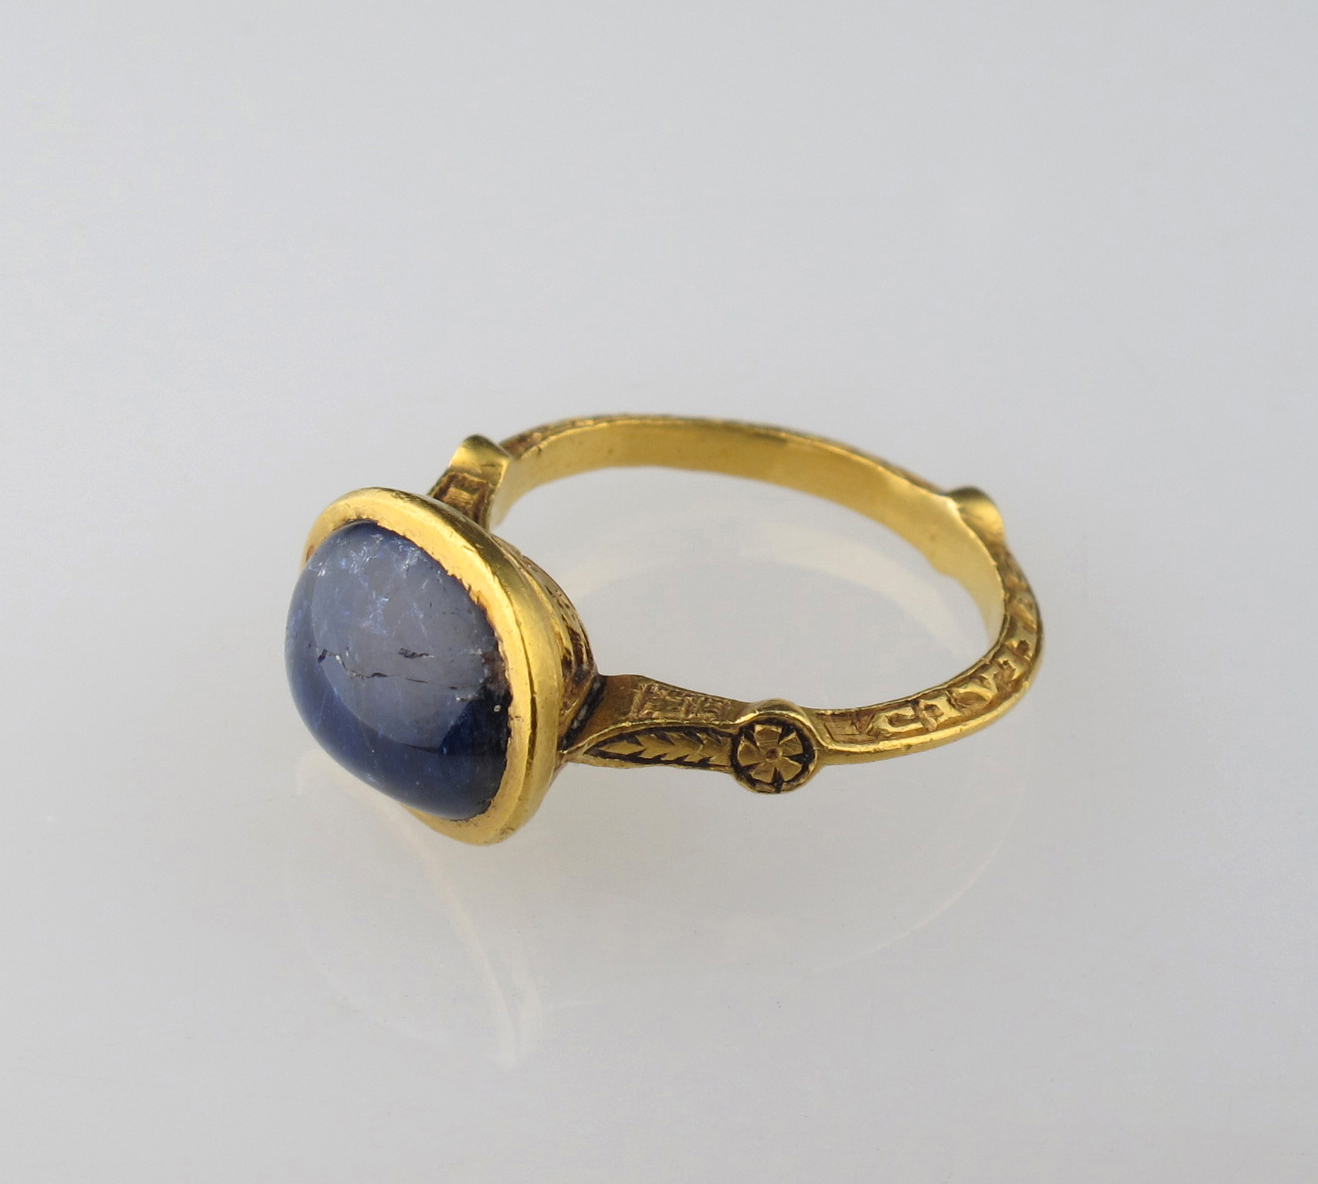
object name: ring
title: Finger Ring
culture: british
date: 1301-1400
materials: gold, gemstone